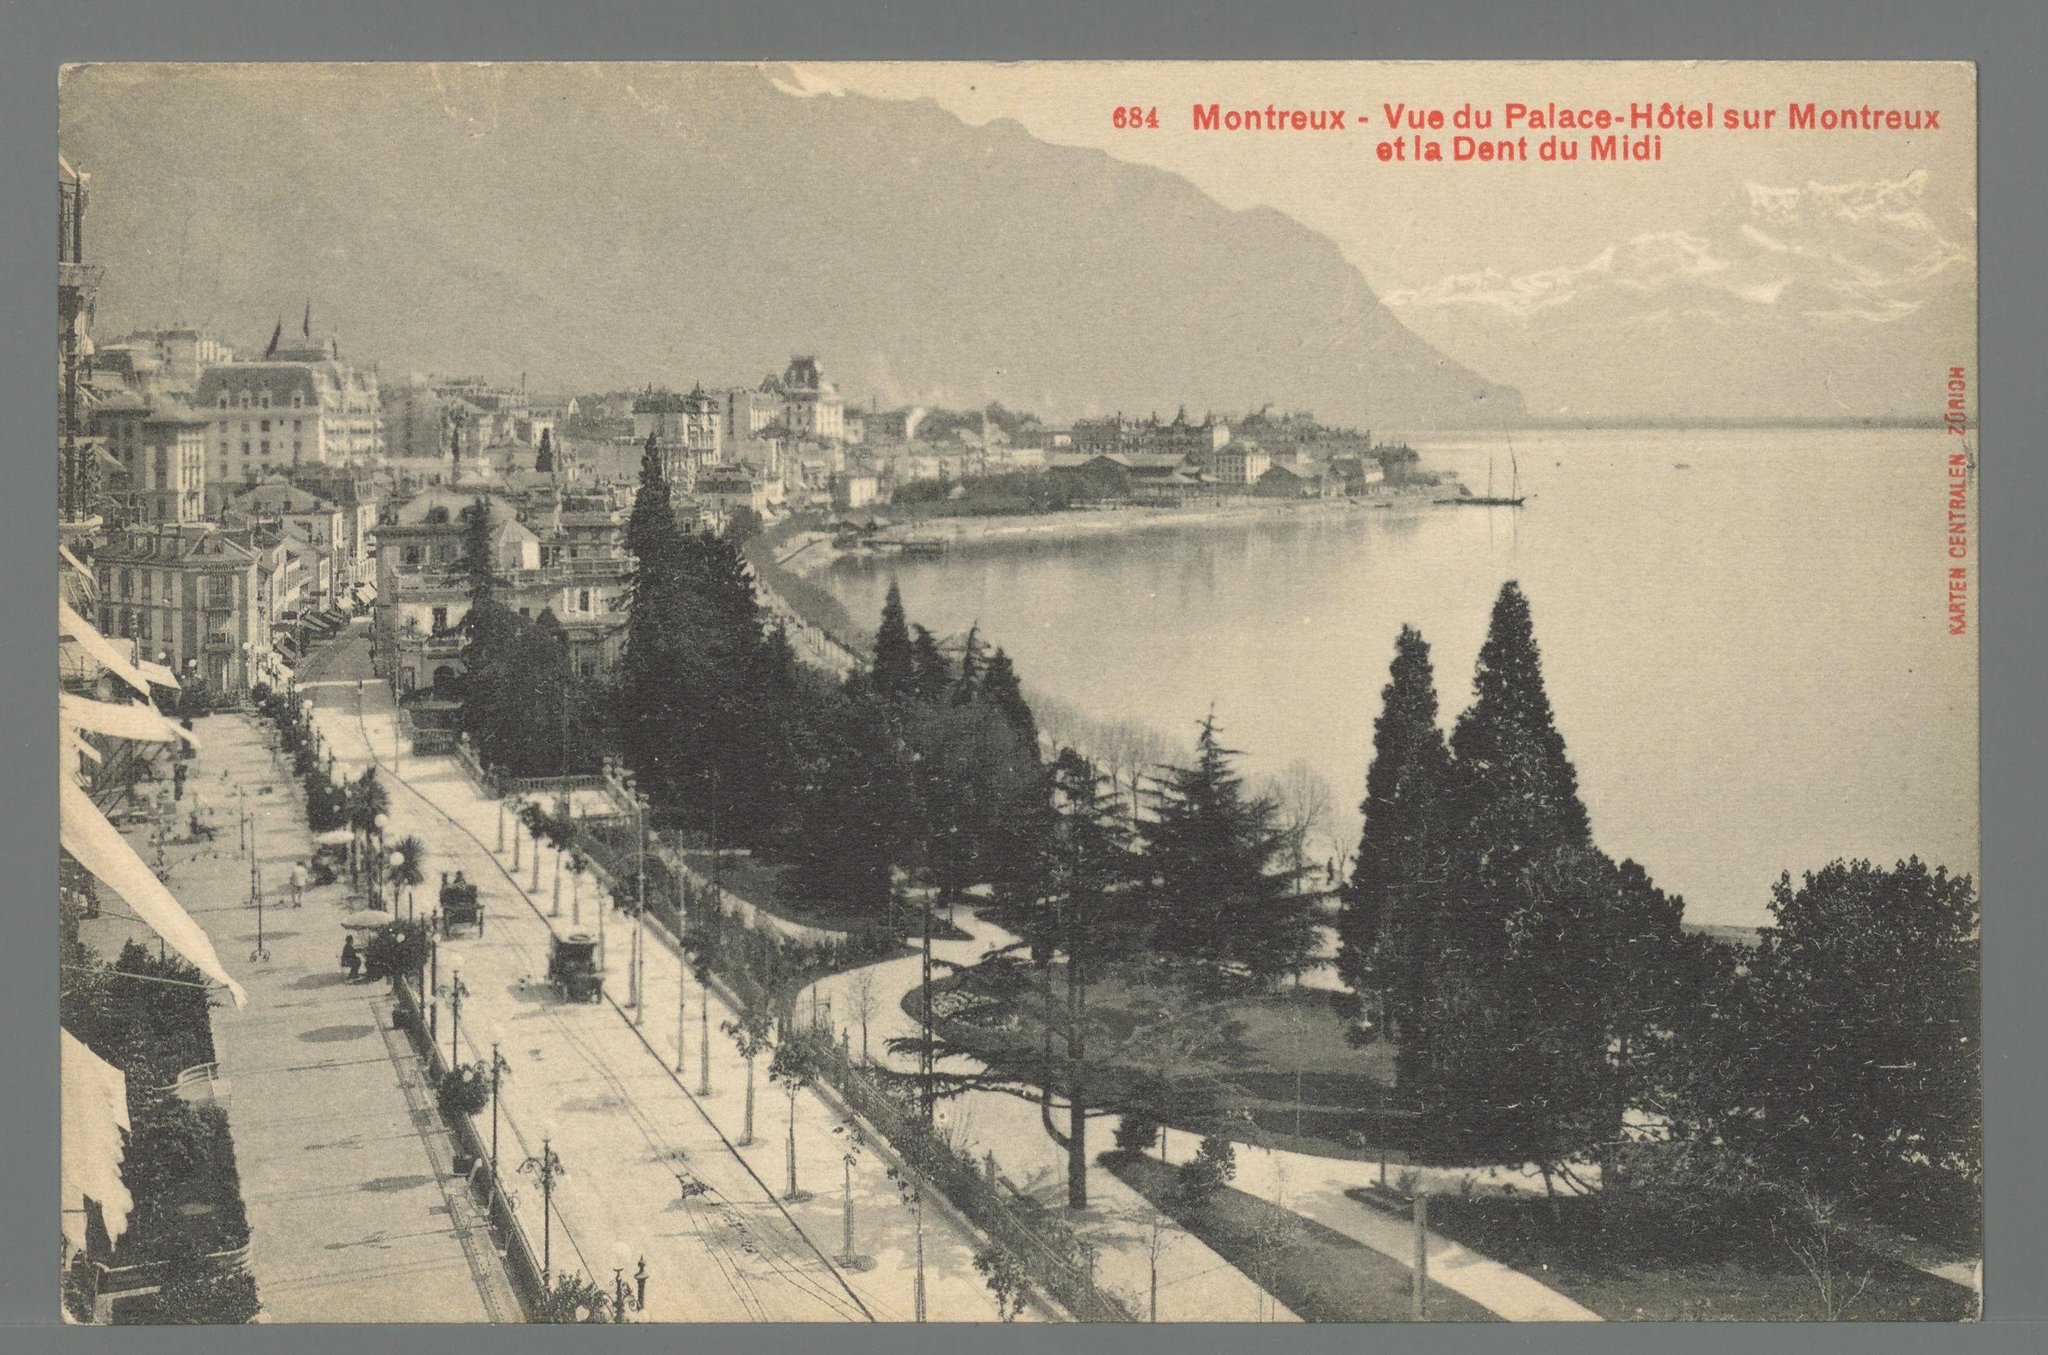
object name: photomechanical print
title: Montreux. Vue du Palace-Hôtel sur Montreux et la Dent du Midi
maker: Anonymous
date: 1905-1909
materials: cardboard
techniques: photograph, writing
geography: montreux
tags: lake, mountain-range, snow peaks, city-view, and landscape with man-made constructions (+ city(-scape) with figures, staffage)